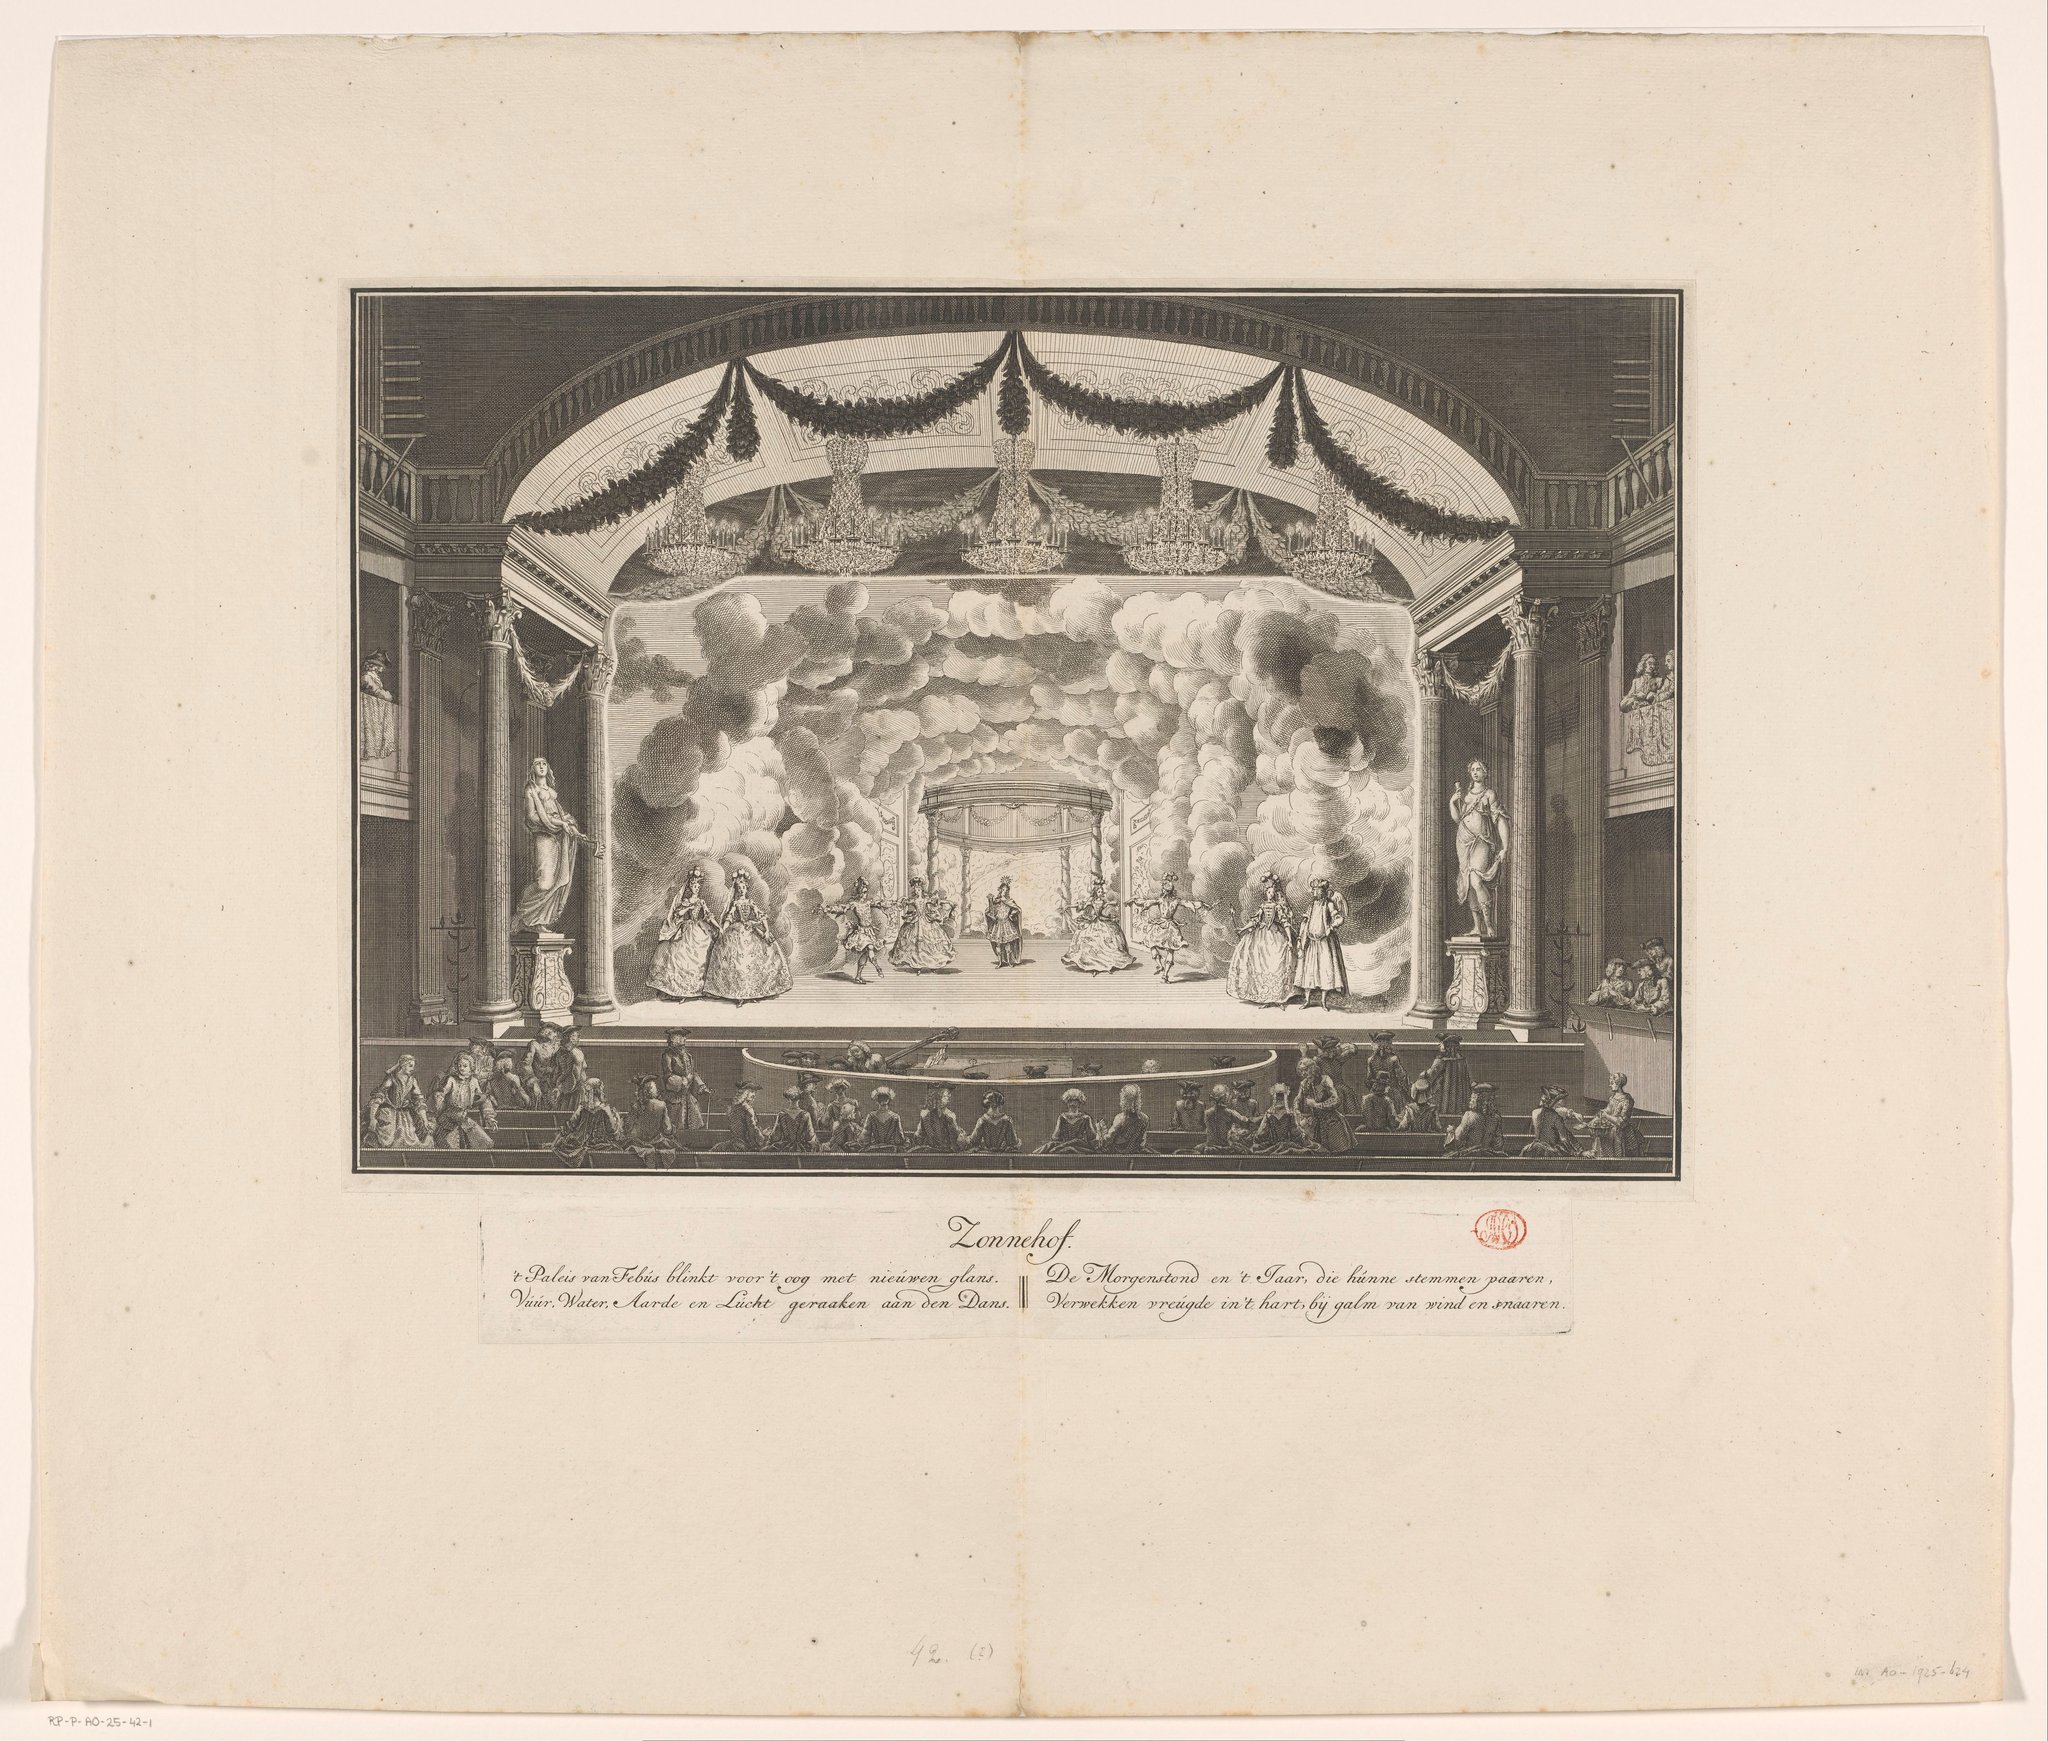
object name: print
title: Zonnehof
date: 1738-1740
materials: paper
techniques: engraving, etching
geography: amsterdam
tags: theatre, theatrical performance, stage design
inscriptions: collector's mark: Lugt 195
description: Toneelvoorstelling in de Amsterdamse Schouwburg op de Keizersgracht met het coulissendecor Zonnehof met scène uit: Het eeuwgetijde van den Amsteldamschen Schouwburg. Het decor gedrukt van een aparte plaat binnen een passe-partout met de zaal, zijloges, orkestbak en de façade van het toneel met zuilen, guirlandes en kroonluchters. De titel en een vierregelig vers ook gedrukt van een aparte plaat. Onderdeel van een serie van 12 toneeldecors.